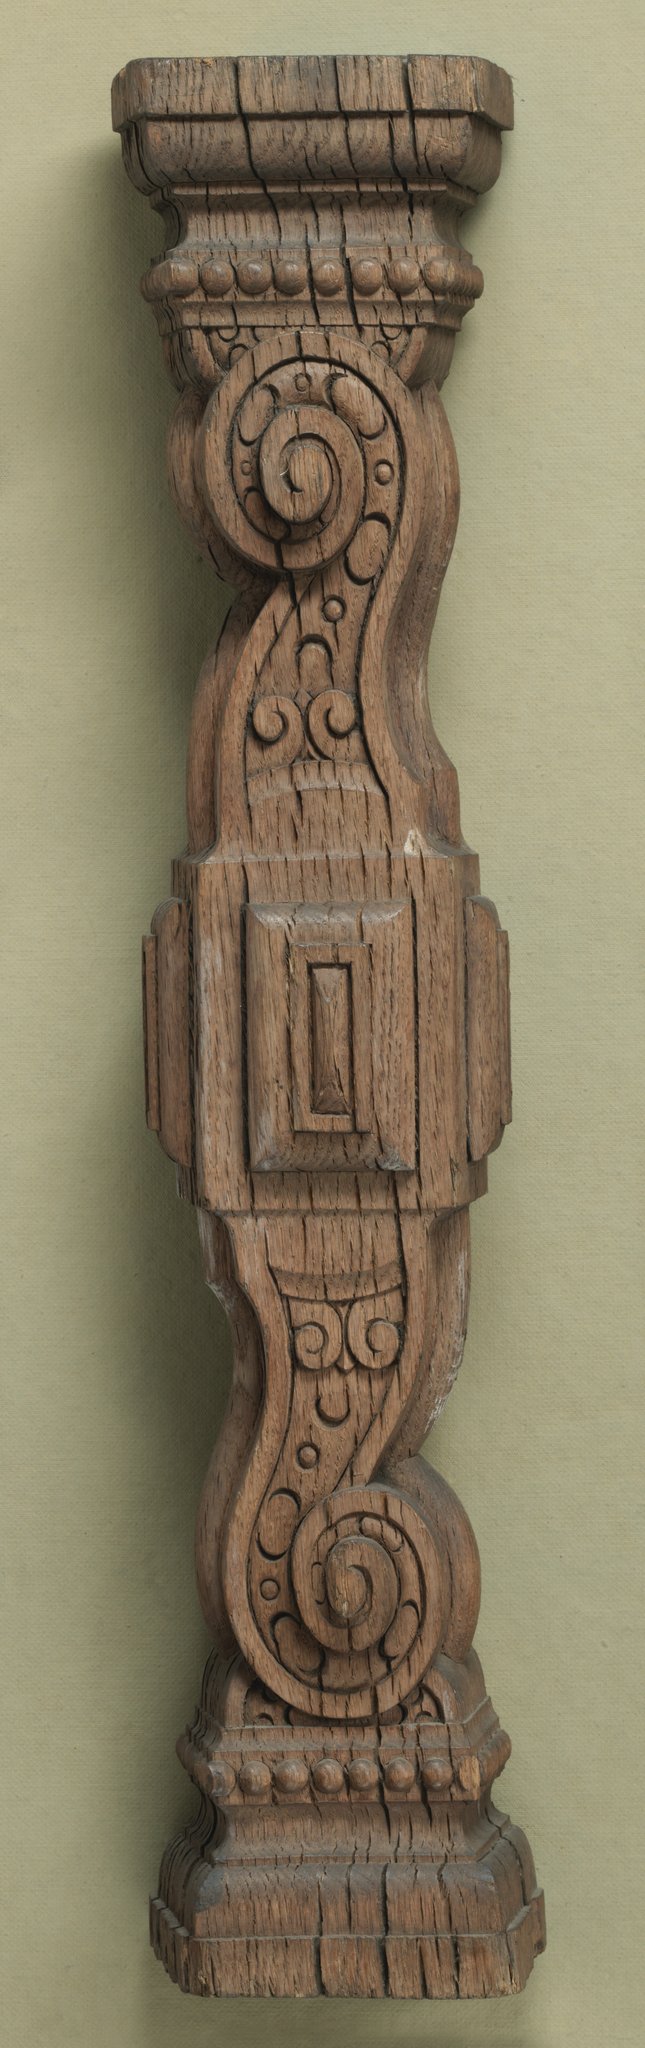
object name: baluster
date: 1601-1633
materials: wood